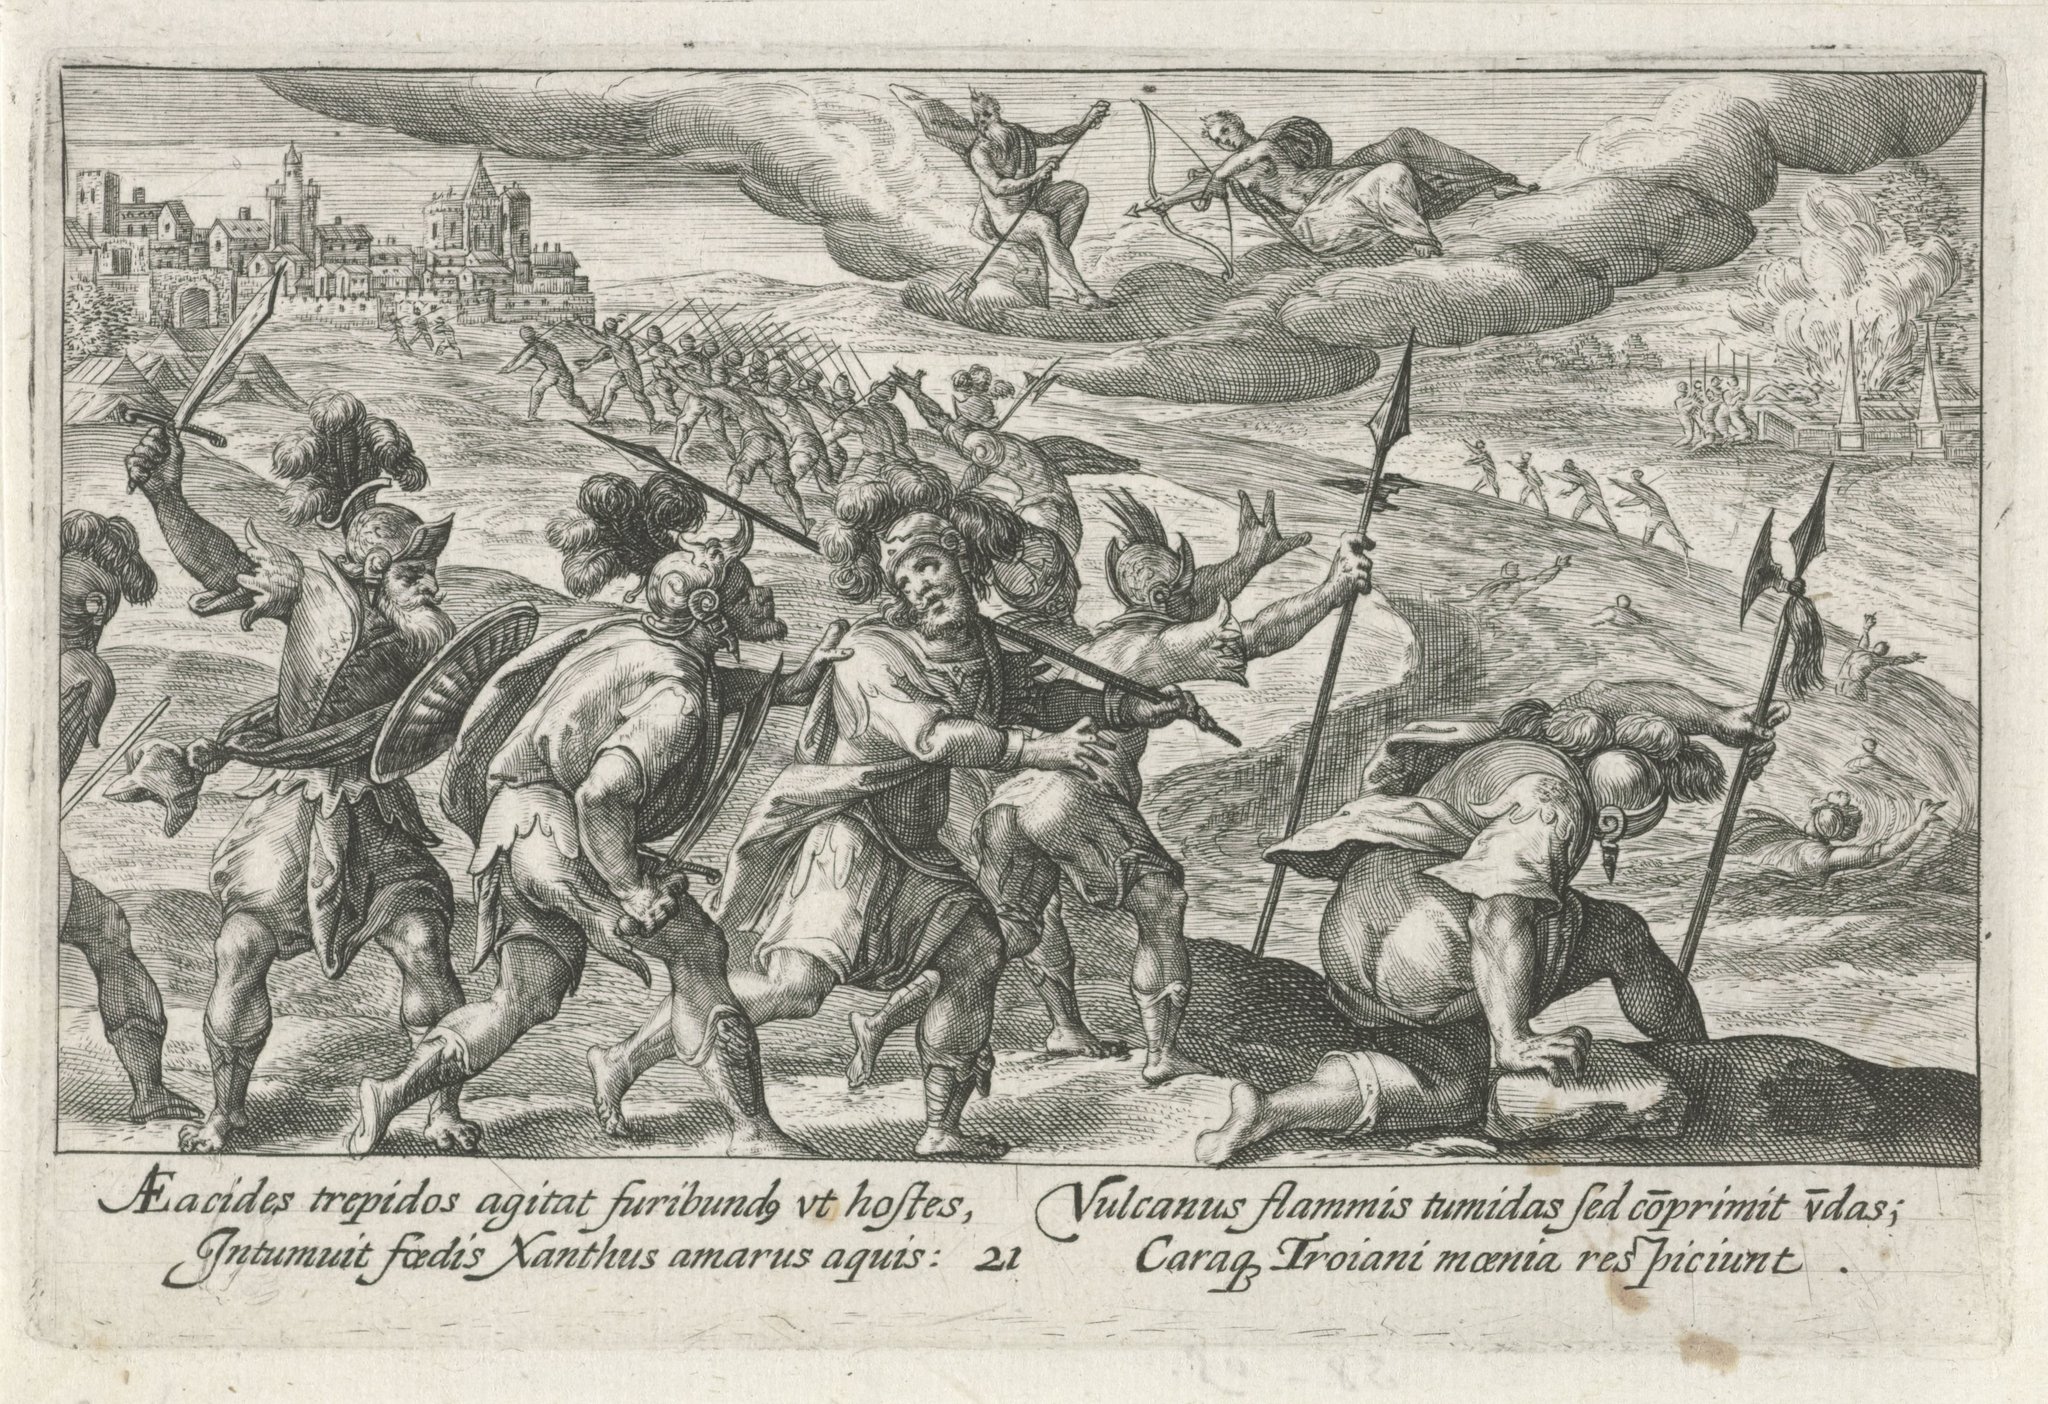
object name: print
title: Het gevecht bij de rivier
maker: crispijn van de passe (i)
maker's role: draughtsman, print maker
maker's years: 1564-1637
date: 1613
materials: paper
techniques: engraving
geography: utrecht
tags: last deeds and death of achilles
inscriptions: number: ‘38-65’, collector's mark: Lugt 240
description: Achilles krijgt hulp van Neptunus en Minerva tijdens zijn gevecht met de rivier Xanthus. In de marge een vierregelig onderschrift, in twee kolommen, in het Latijn.